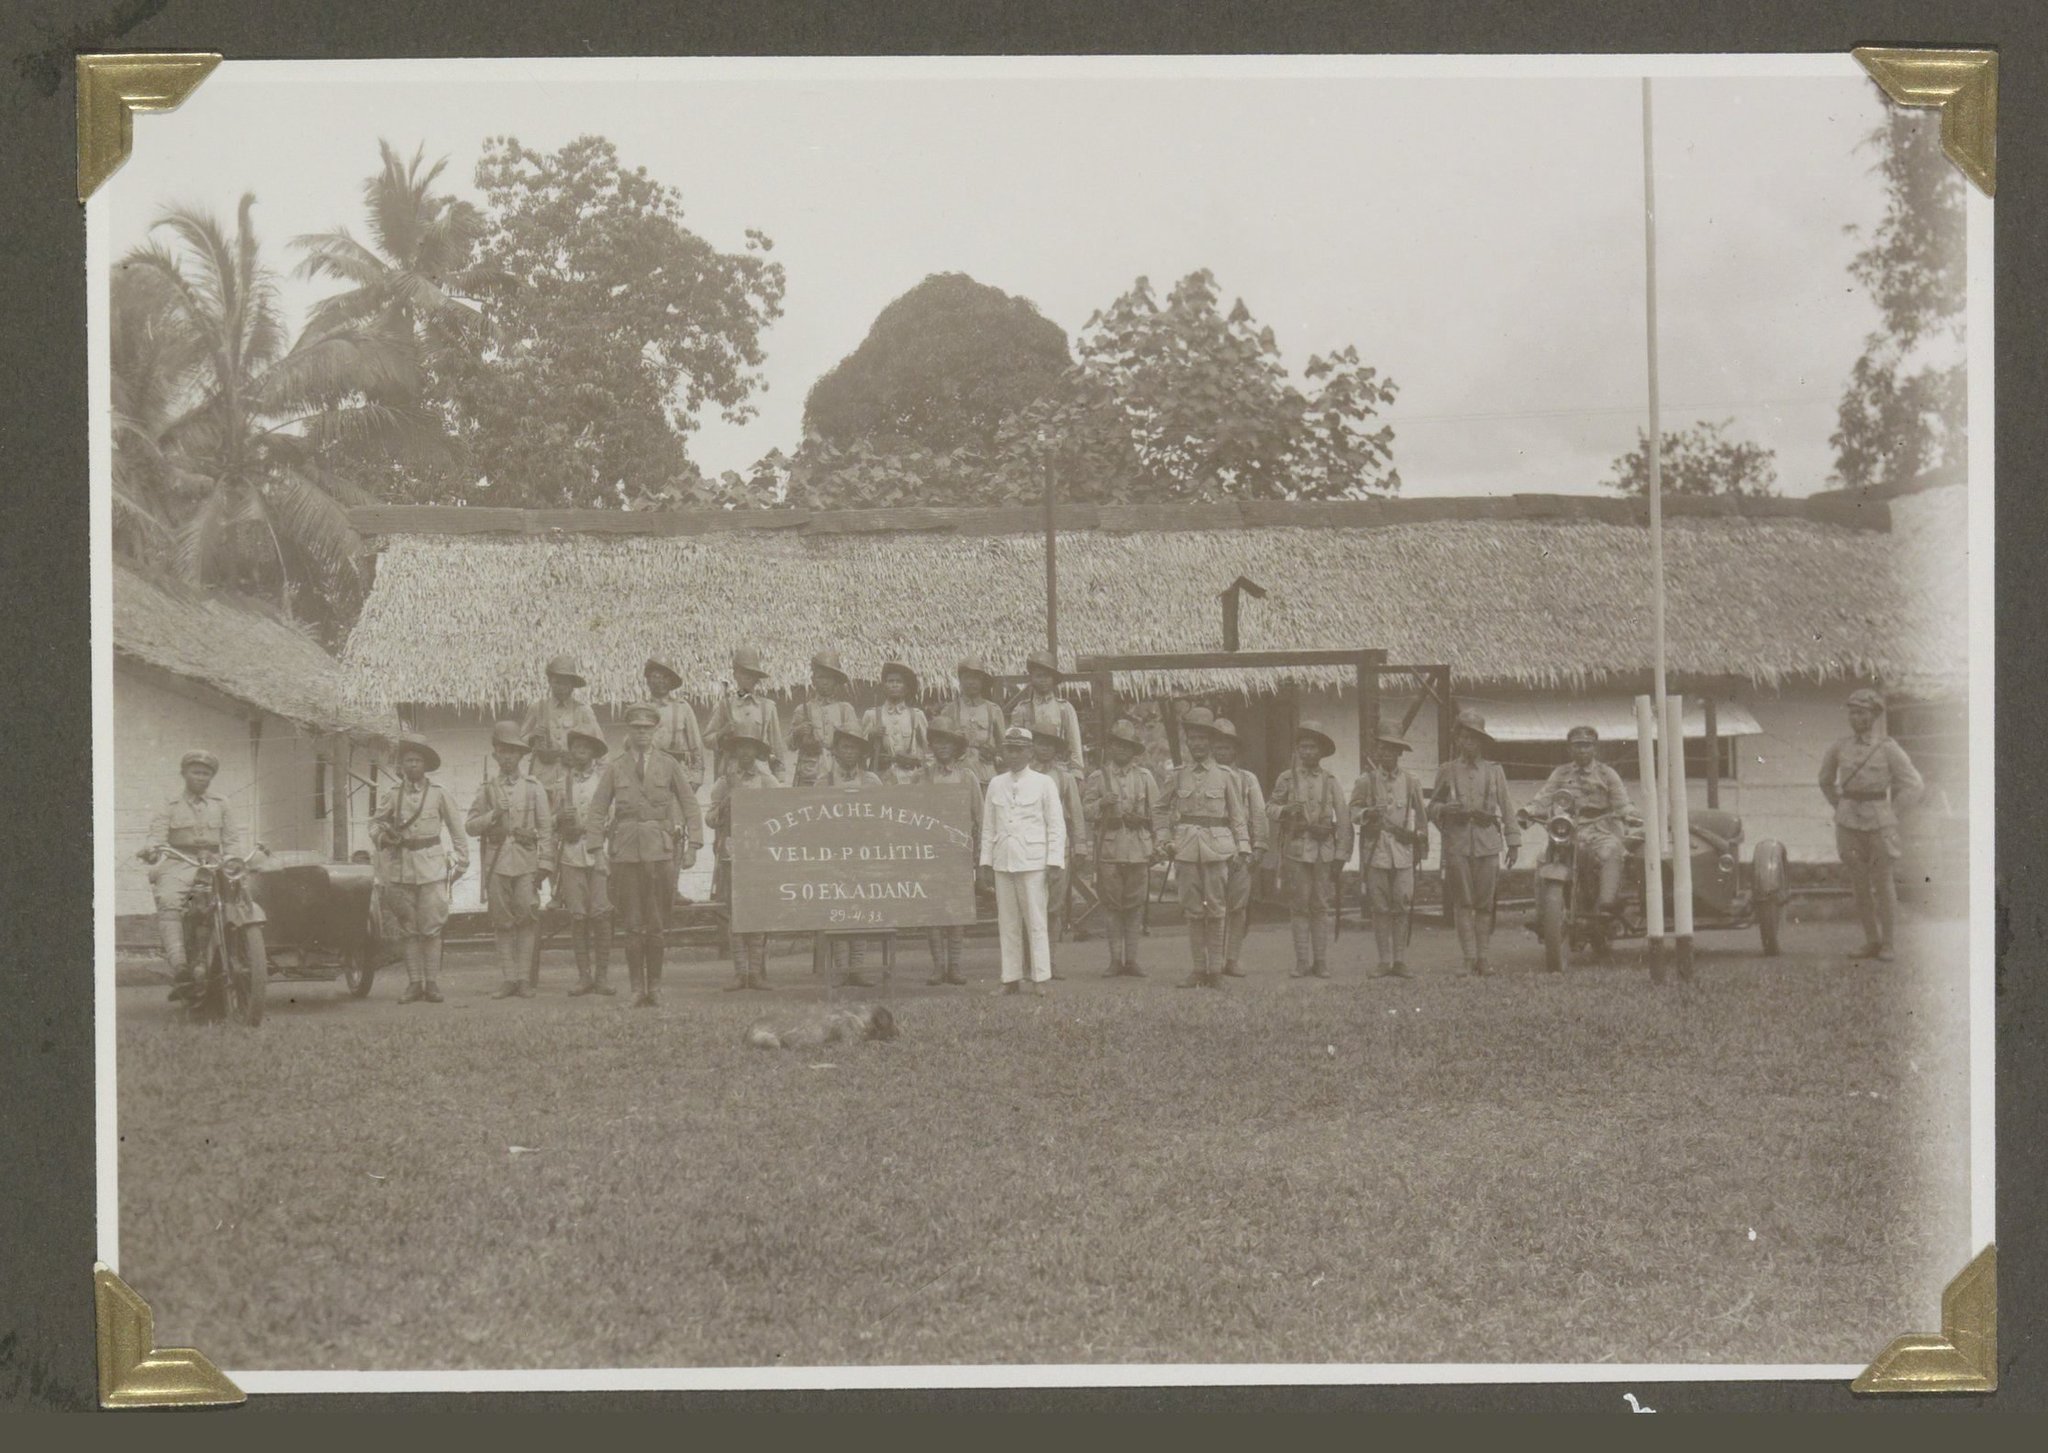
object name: photograph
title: Groepsportret van de veldpolitie van Soekadana (Zuid-Sumatra)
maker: Anonymous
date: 1933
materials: photographic support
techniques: gelatin silver print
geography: lampung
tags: police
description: Onderdeel van Herinneringsalbum voor F.J. Junius, vertrekkend resident van Lampong (Zuid-Sumatra).